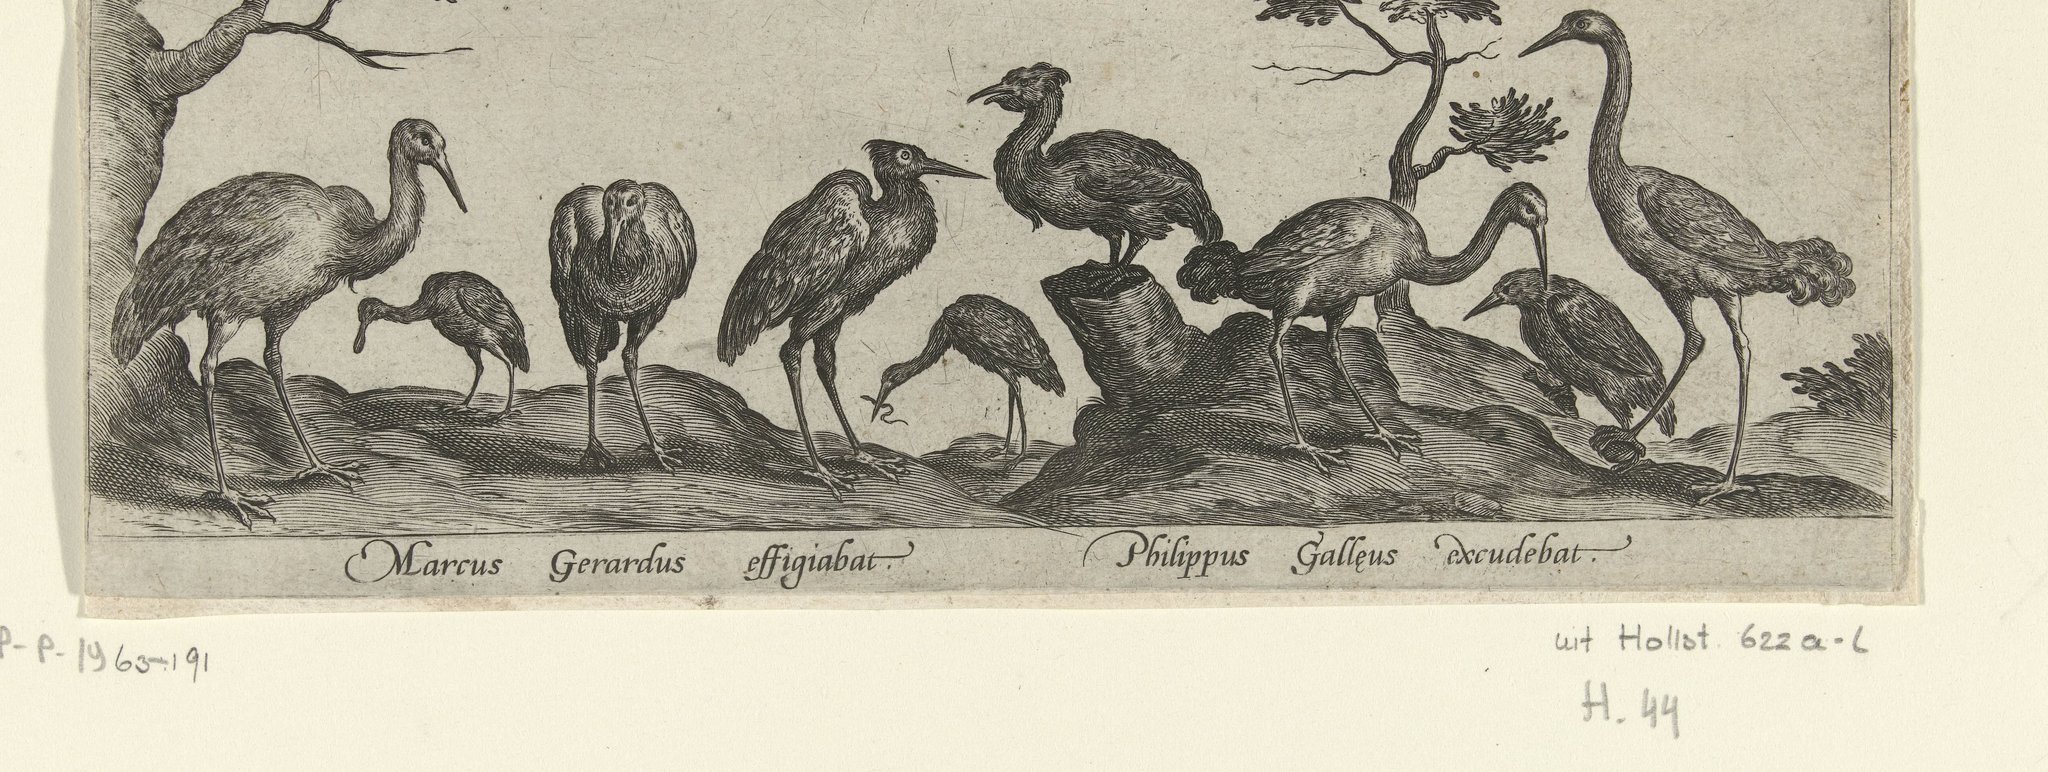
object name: print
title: Steltlopers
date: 1547-1590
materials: paper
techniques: engraving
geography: antwerp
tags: shore-birds and wading-birds: bittern, shore-birds and wading-birds: spoonbill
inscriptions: collector's mark: Lugt 2760, collector's mark: Lugt 2228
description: Negen steltlopers, waaronder een lepelaar en een roerdomp. De prent maakt deel uit van een prentserie over vogels en vlinders.